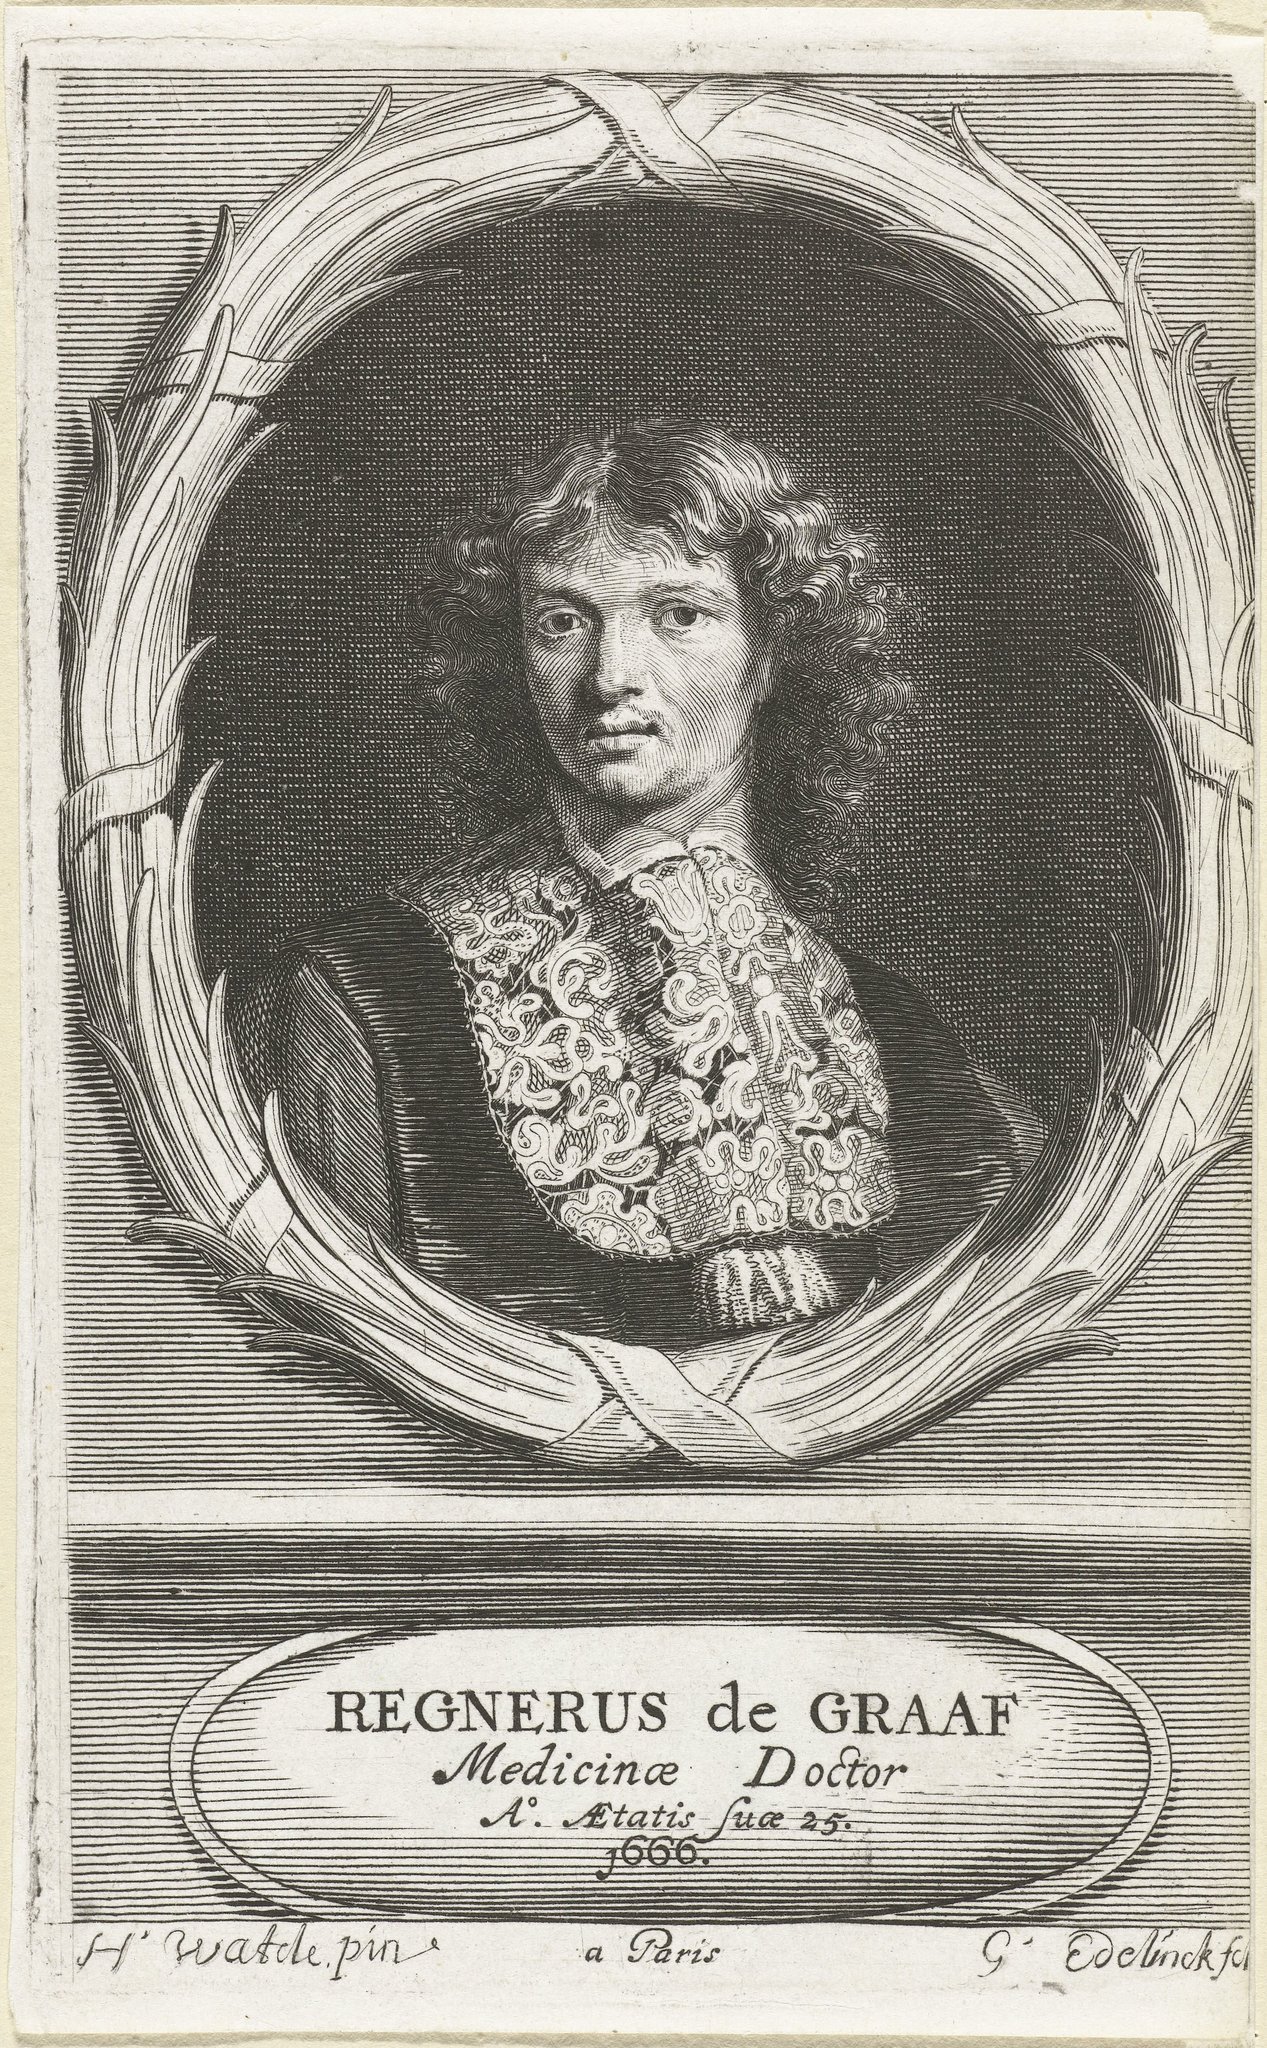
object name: print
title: Portret van Reinier de Graaf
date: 1666-1707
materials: paper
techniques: engraving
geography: paris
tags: delft, reinier de graaf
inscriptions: collector's mark: Lugt 240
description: Portret van de Nederlandse arts Reinier de Graaf (1641-1673), afgebeeld in ovale omlijsting van bijeen gebonden palmbladeren.